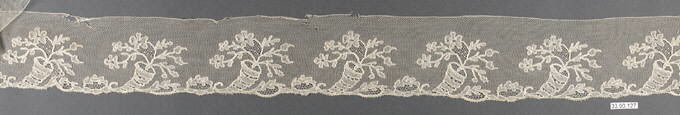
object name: edging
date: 1701-1800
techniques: lace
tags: flowers